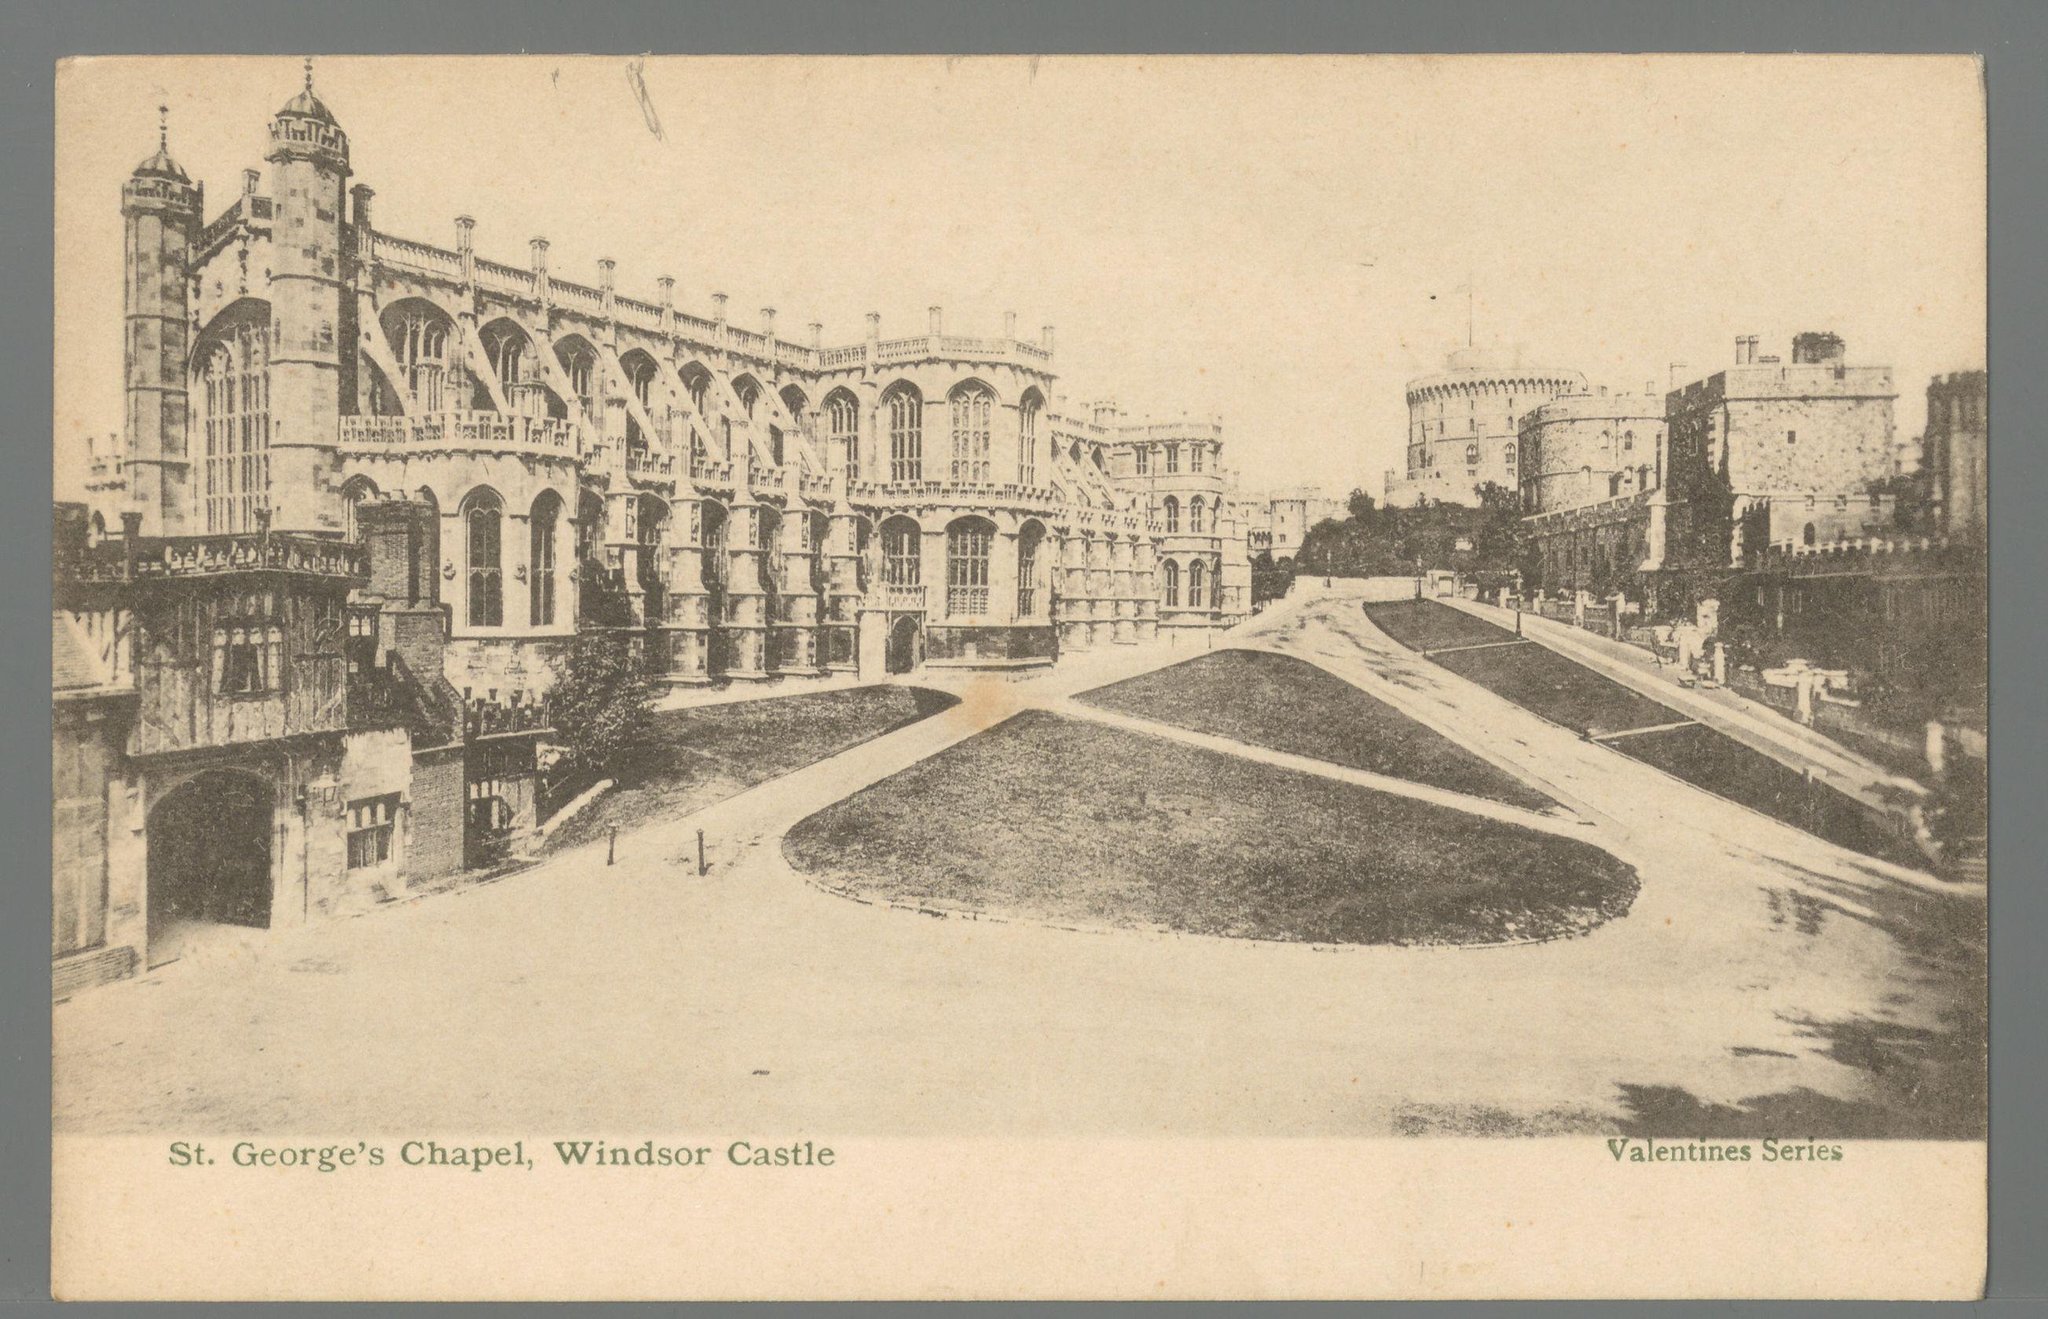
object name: photomechanical print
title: St. George's Chapel, Windsor Castle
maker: Anonymous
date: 1902-1930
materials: cardboard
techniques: photograph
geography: windsor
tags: castle, garden, church (exterior) - qq - small church, chapel